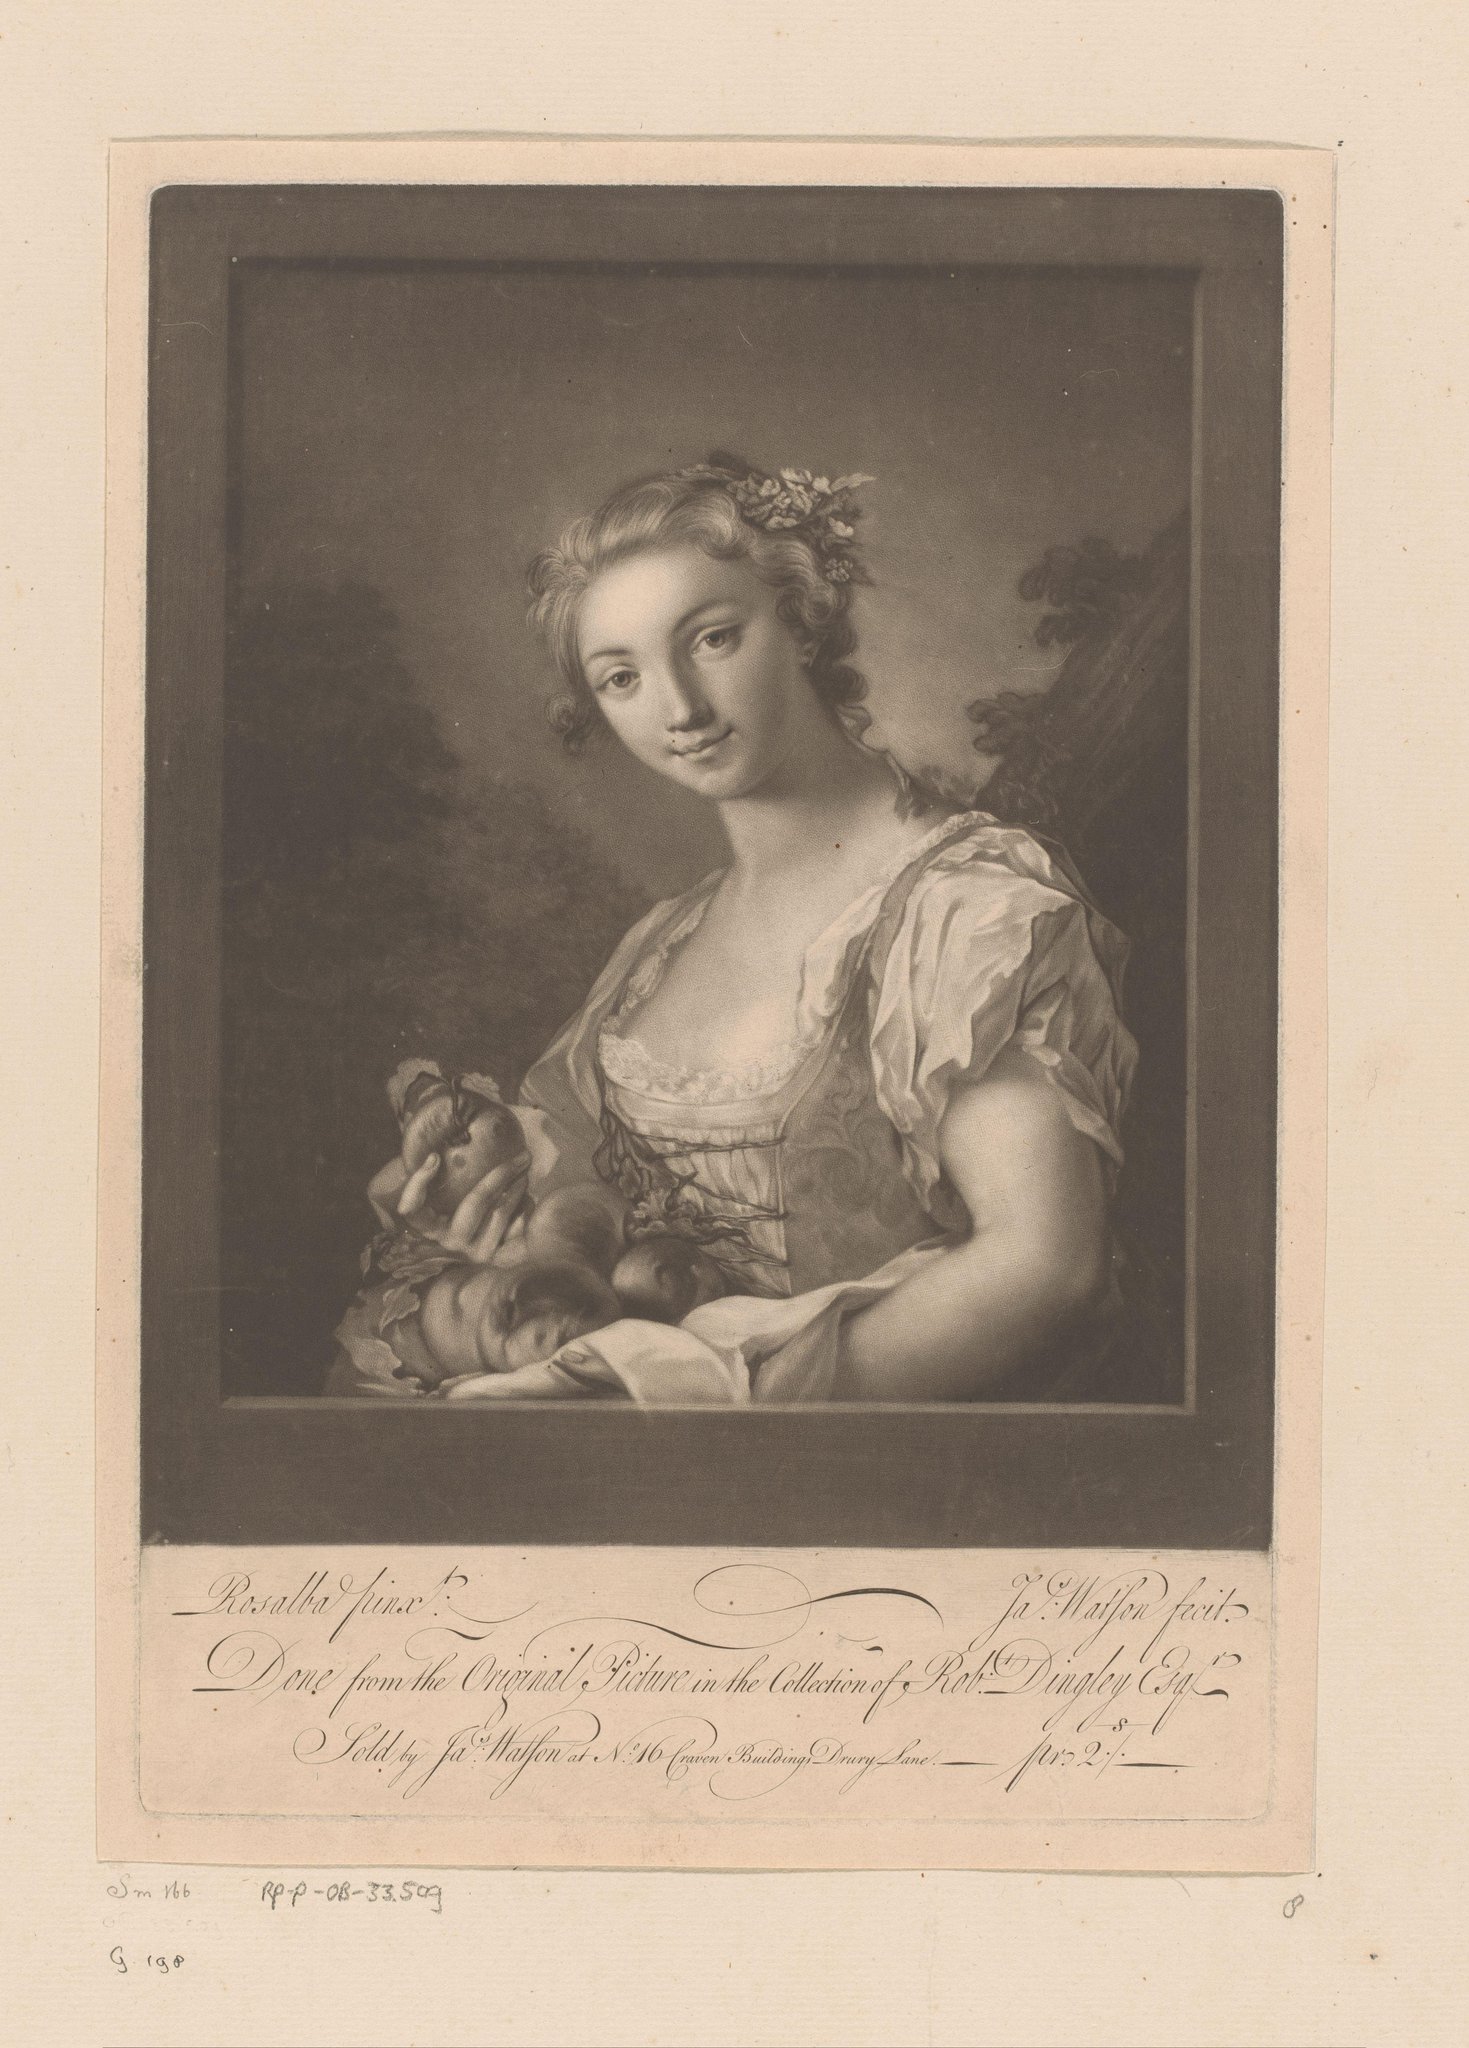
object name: print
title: Jonge glimlachende vrouw met perziken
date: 1760-1790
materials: paper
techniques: mezzotint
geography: london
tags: smiling, fruits: peach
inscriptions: collector's mark: Lugt 240